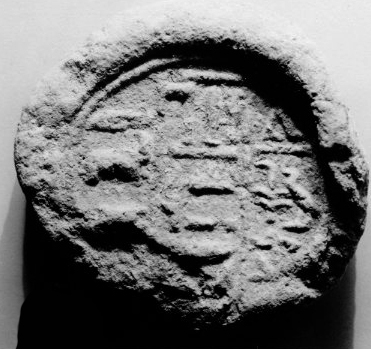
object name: cone, circular impression, nebansu, sailor, amun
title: Funerary Cone of the Sailor of Amun Nebansu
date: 1550-1295 BCE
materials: pottery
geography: egypt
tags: hieroglyphs